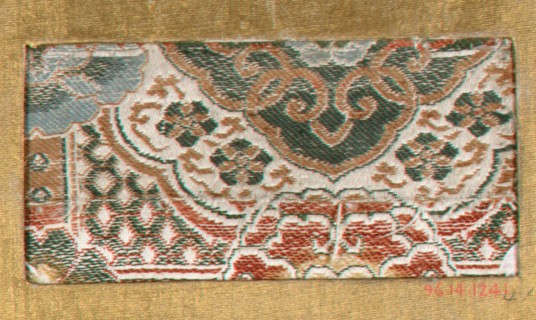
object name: piece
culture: japanese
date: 1701-1900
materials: silk